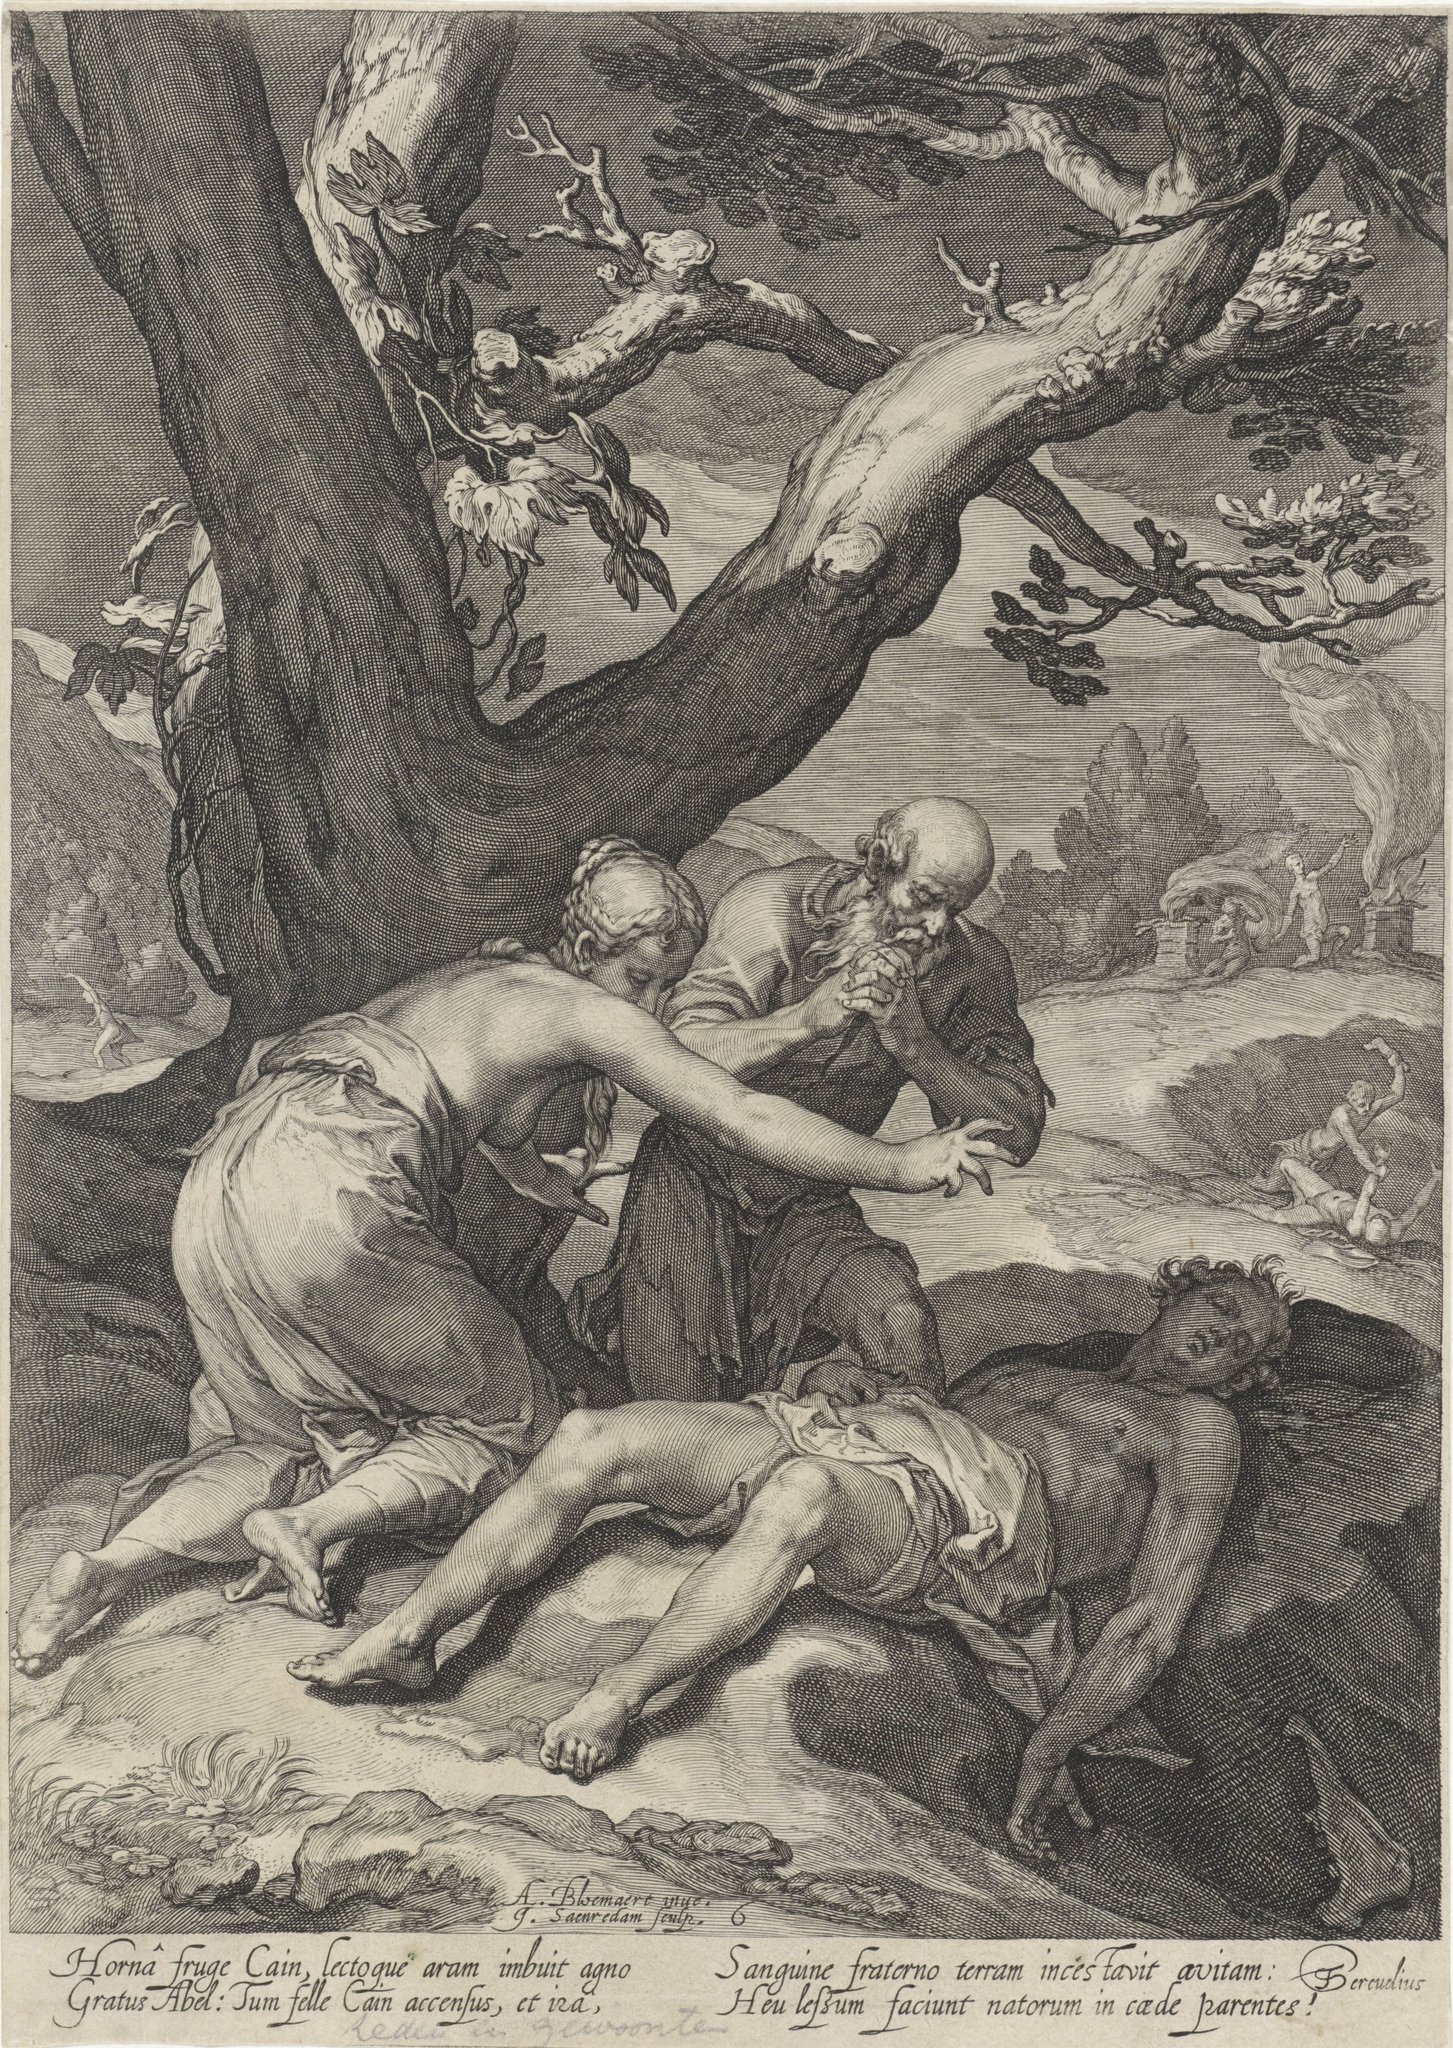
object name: print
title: Adam en Eva treuren om de dood van Abel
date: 1604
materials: paper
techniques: engraving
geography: assendelft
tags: the killing of abel: cain slays him with a stone, a club or a jaw-bone, alternatively with a spade or another tool as weapon, adam and eve discover the dead body of abel and grieve over it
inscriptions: collector's mark: Lugt 240, collector's mark: Lugt 2228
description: Adam en Eva vinden de dode Abel bij de offerplaats. Beiden zitten op hun knieën voor het lijk van hun zoon en treuren. Op de achtergrond het offer van Abel en Kaïn en de moord op Abel.